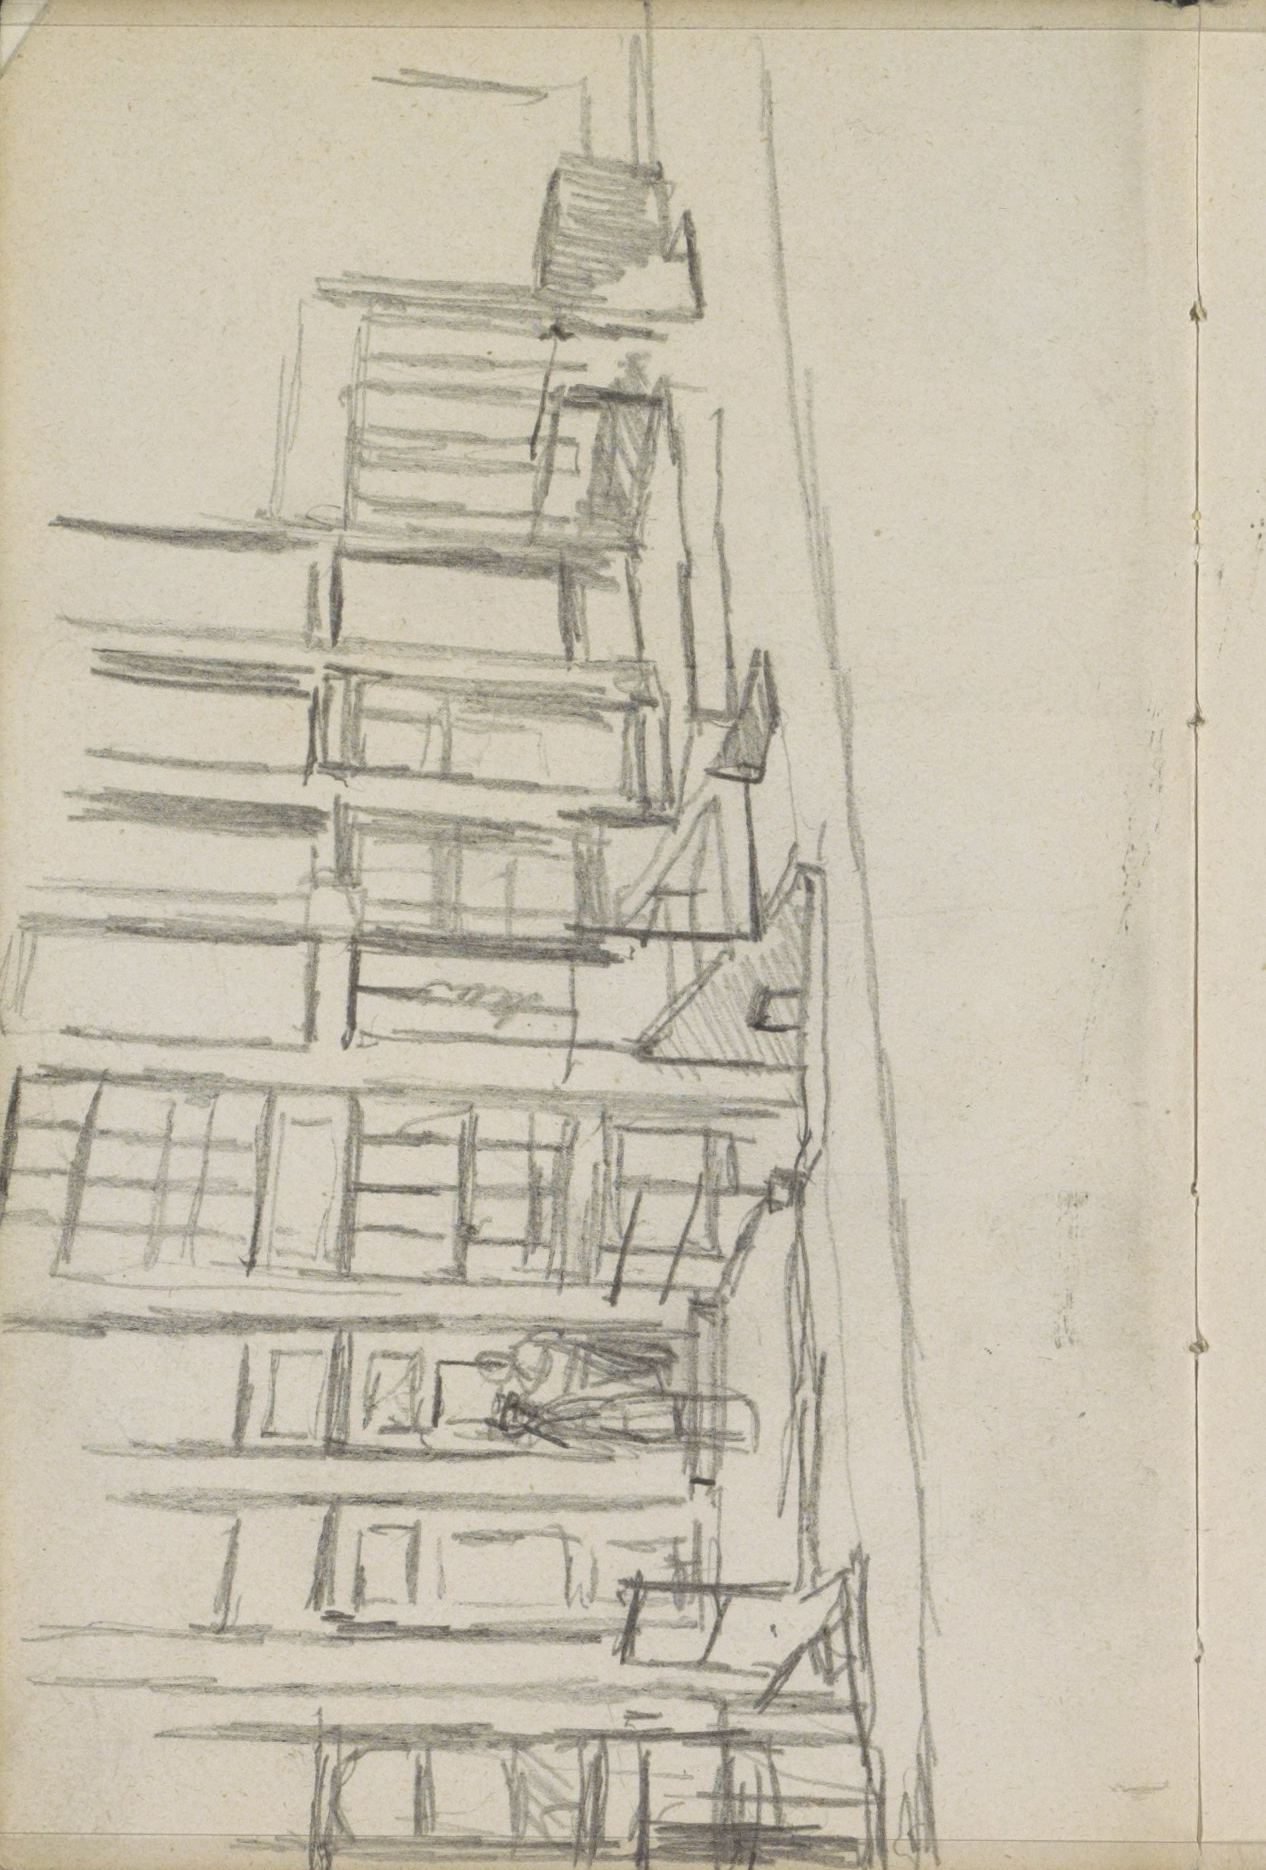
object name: sketchbook leaf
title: Gezicht op een straat in Amsterdam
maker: george hendrik breitner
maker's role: draughtsman, painter, print maker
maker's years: 1857-1923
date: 1886-1903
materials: paper, pencil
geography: amsterdam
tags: urban housing, street (+ city(-scape) with figures, staffage)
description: Pagina 3 uit een schetsboek met 46 bladen.